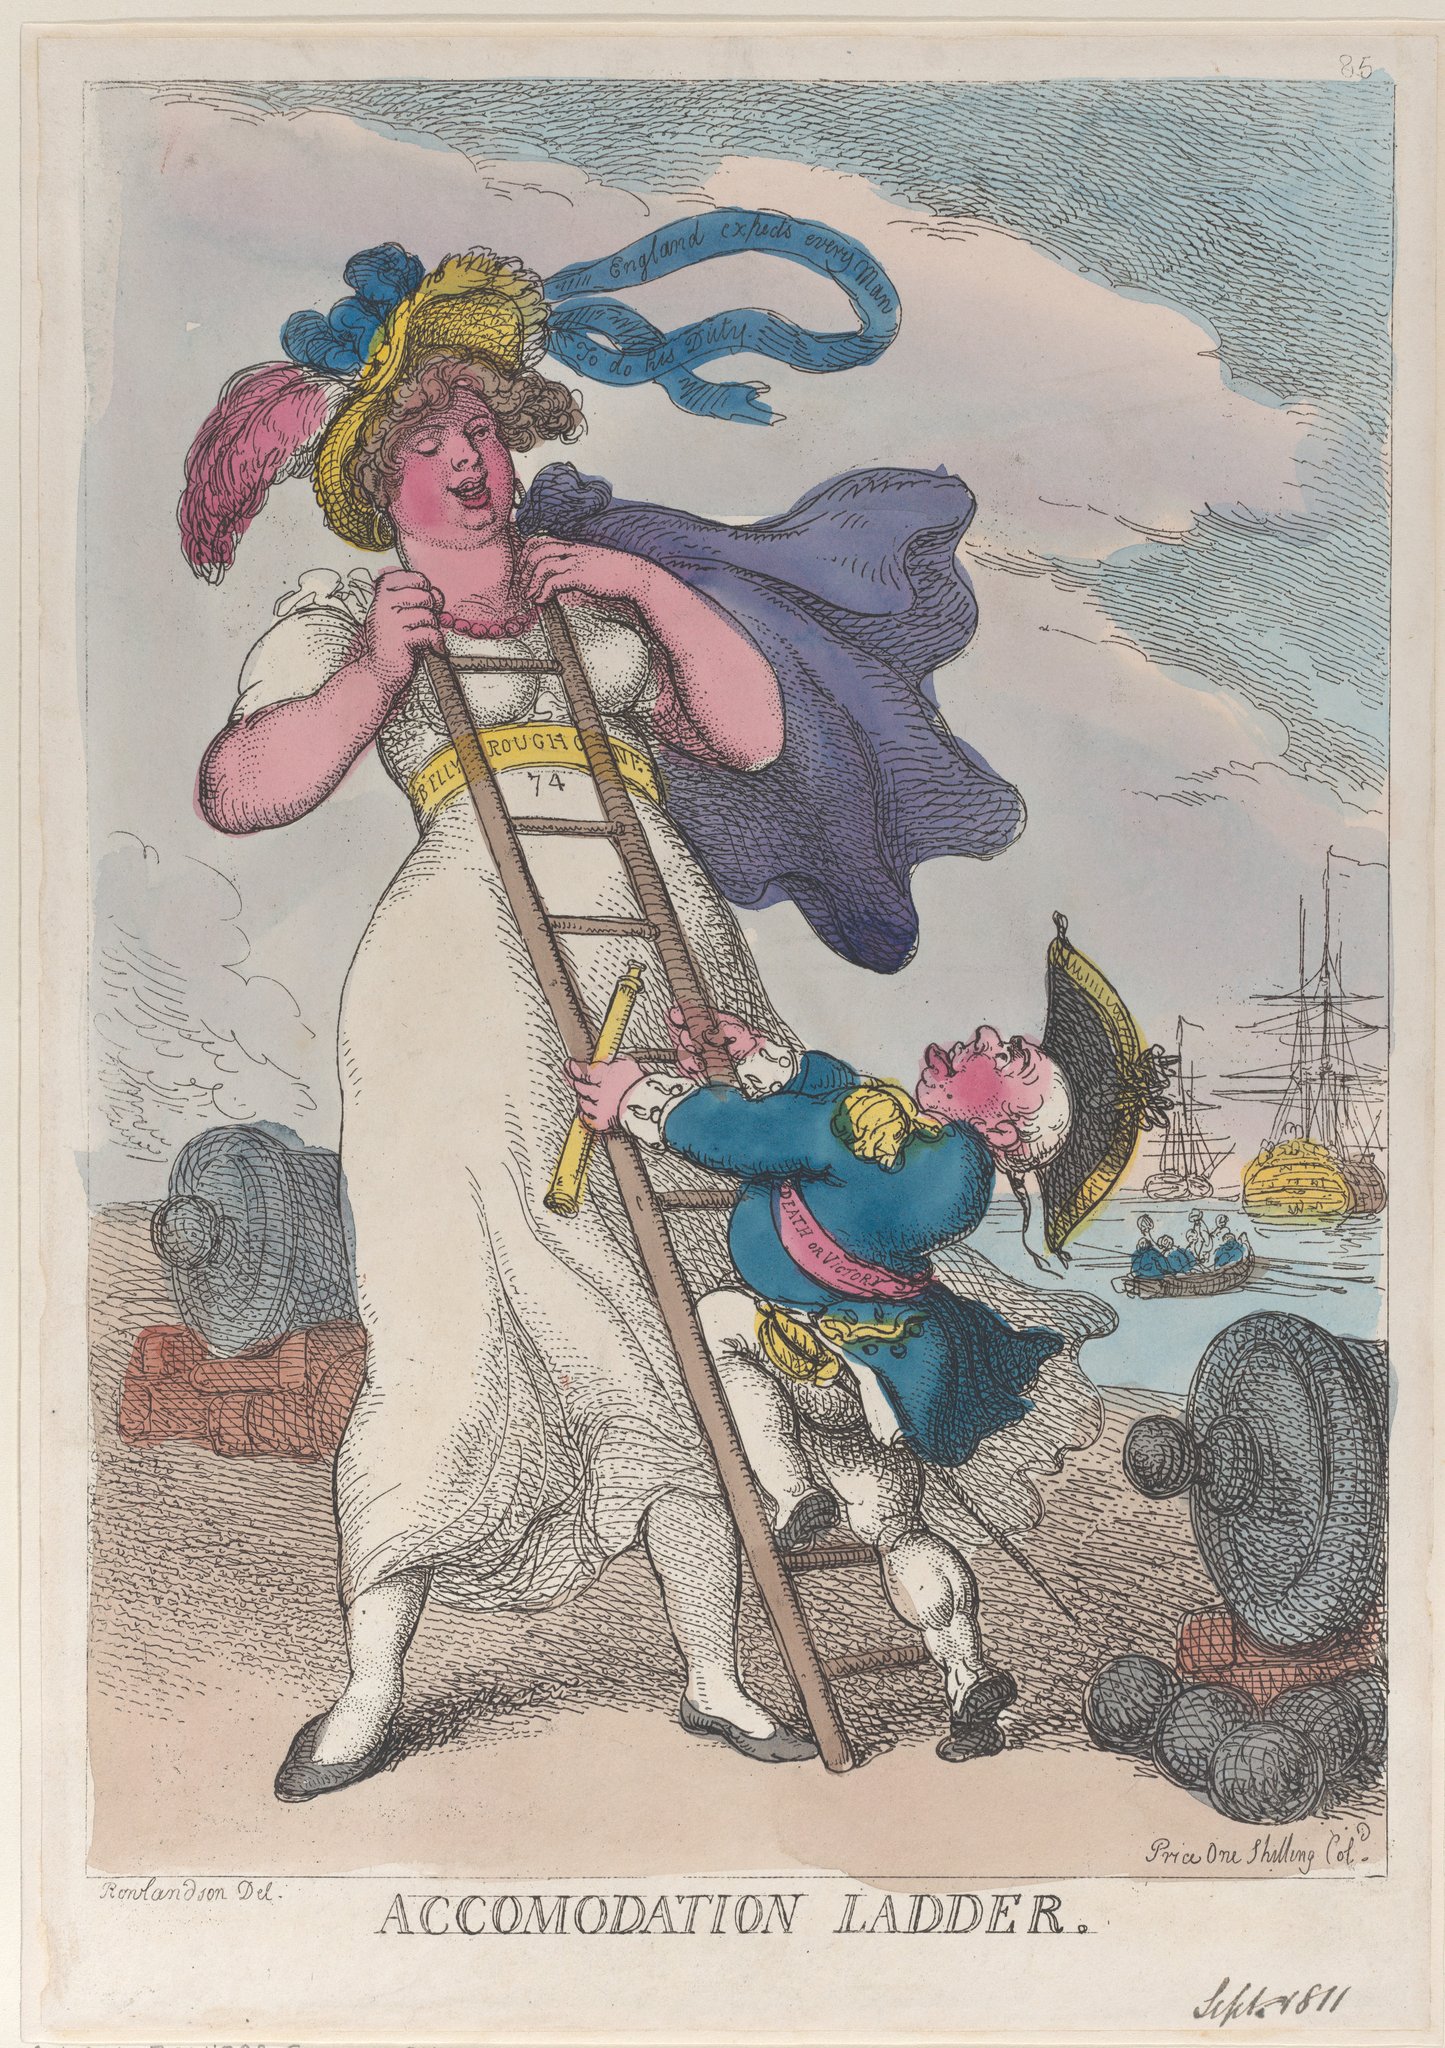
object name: print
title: Accomodation Ladder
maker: thomas rowlandson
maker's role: artist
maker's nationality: british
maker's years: 1757-1827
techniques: etching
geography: london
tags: satire,men,women